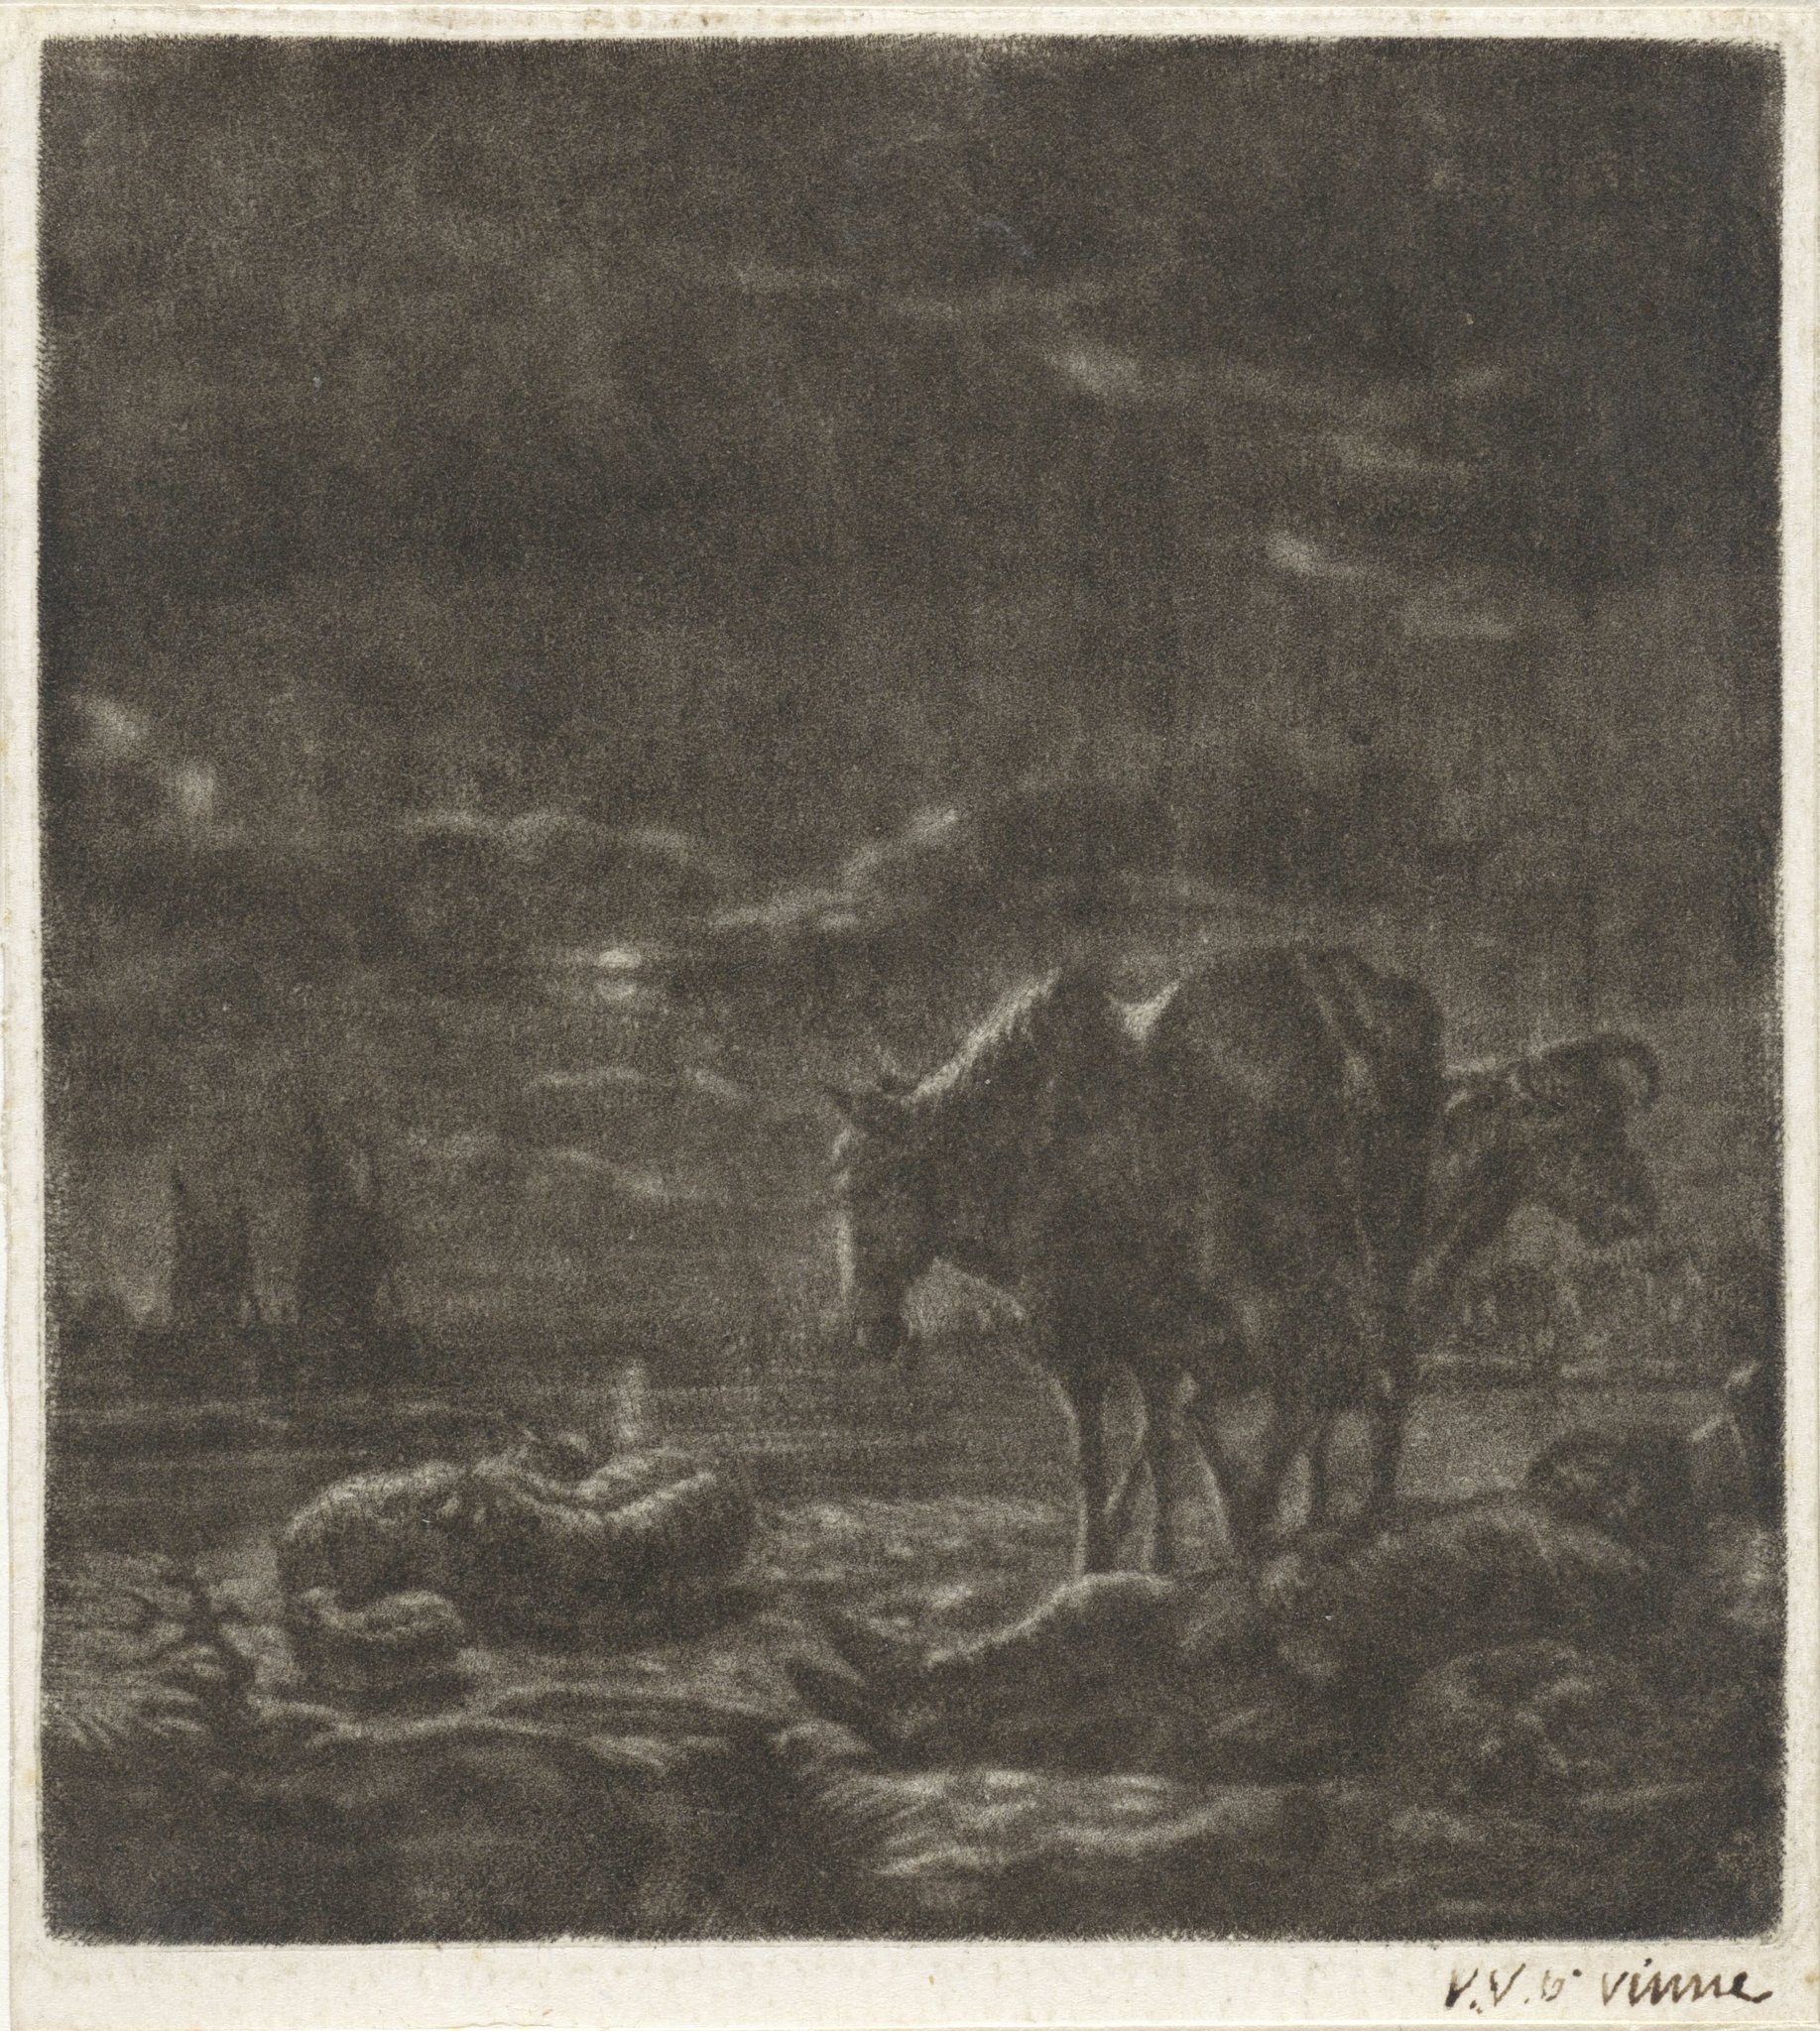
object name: print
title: Nachtlandschap met slapende herder en vee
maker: vincent laurensz. van der vinne (ii)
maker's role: draughtsman, print maker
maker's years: 1686-1742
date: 1696-1742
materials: paper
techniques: mezzotint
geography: haarlem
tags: cow, herding, herdsman, herdswoman, shepherd, shepherdess, cowherd, etc., sleeping; unconsciousness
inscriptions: collector's mark: Lugt 2228, collector's mark: Lugt 2760